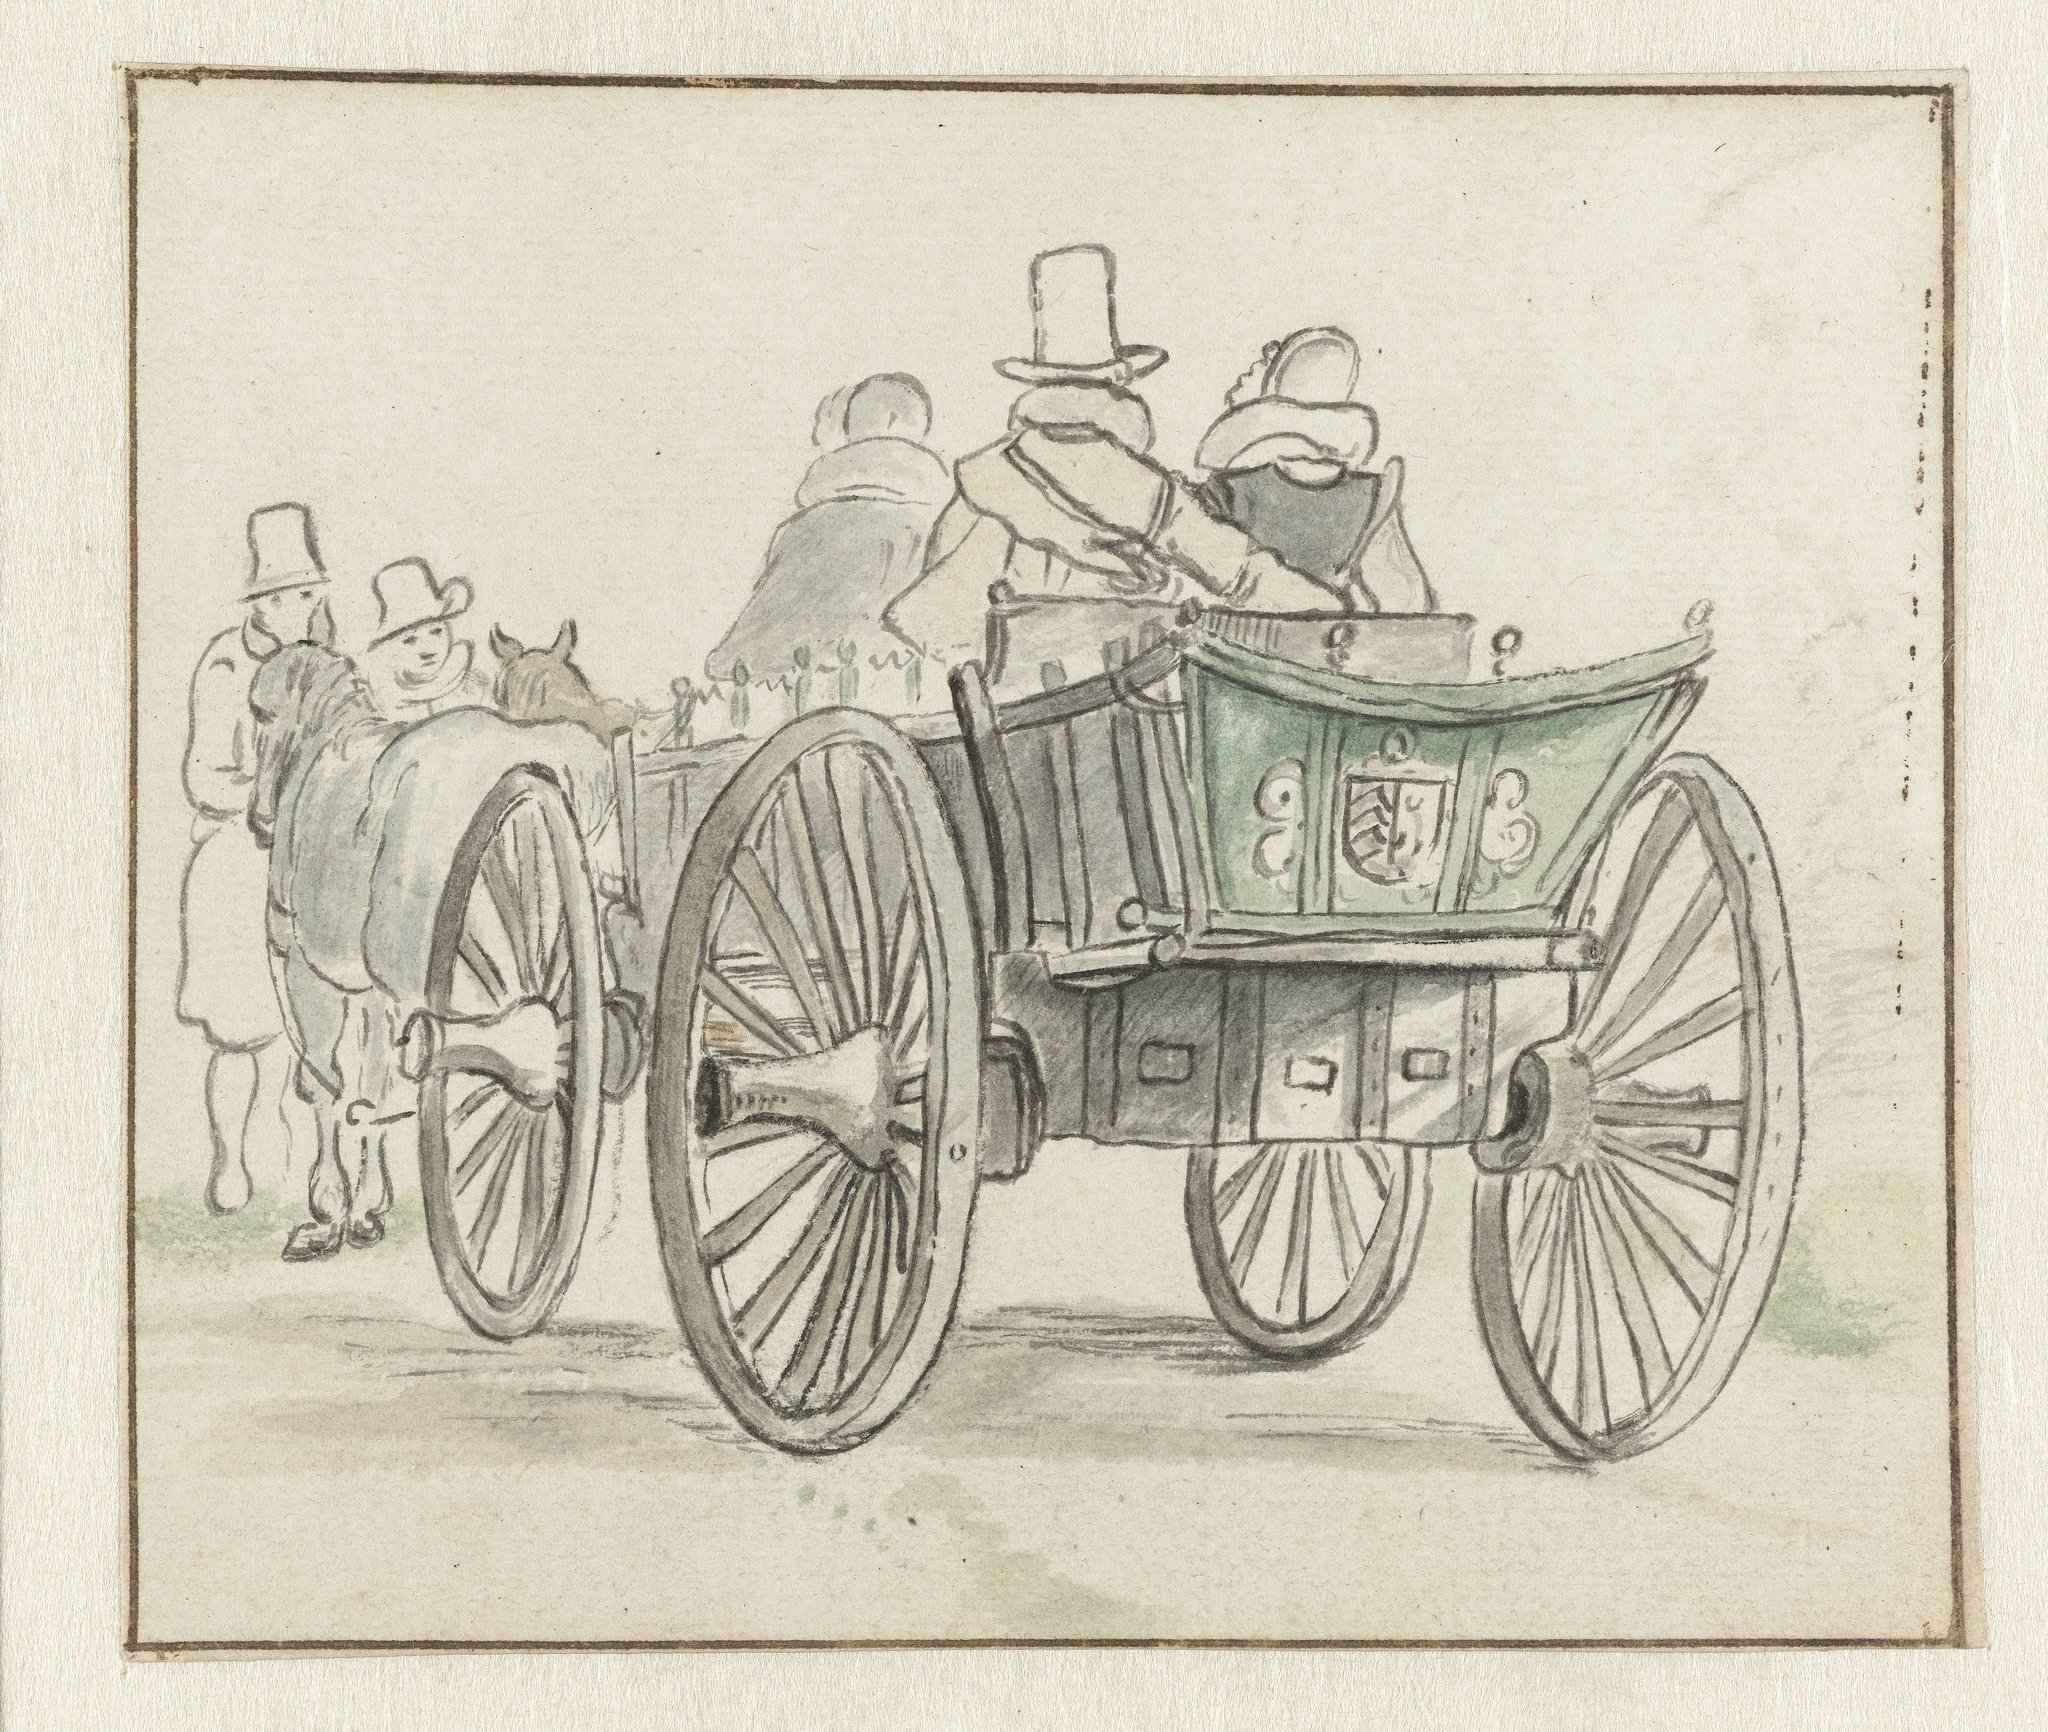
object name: drawing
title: Reiswagen met enkele passagiers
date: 1600-1684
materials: chalk, paper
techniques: brush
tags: four-wheeled vehicle drawn by two animals